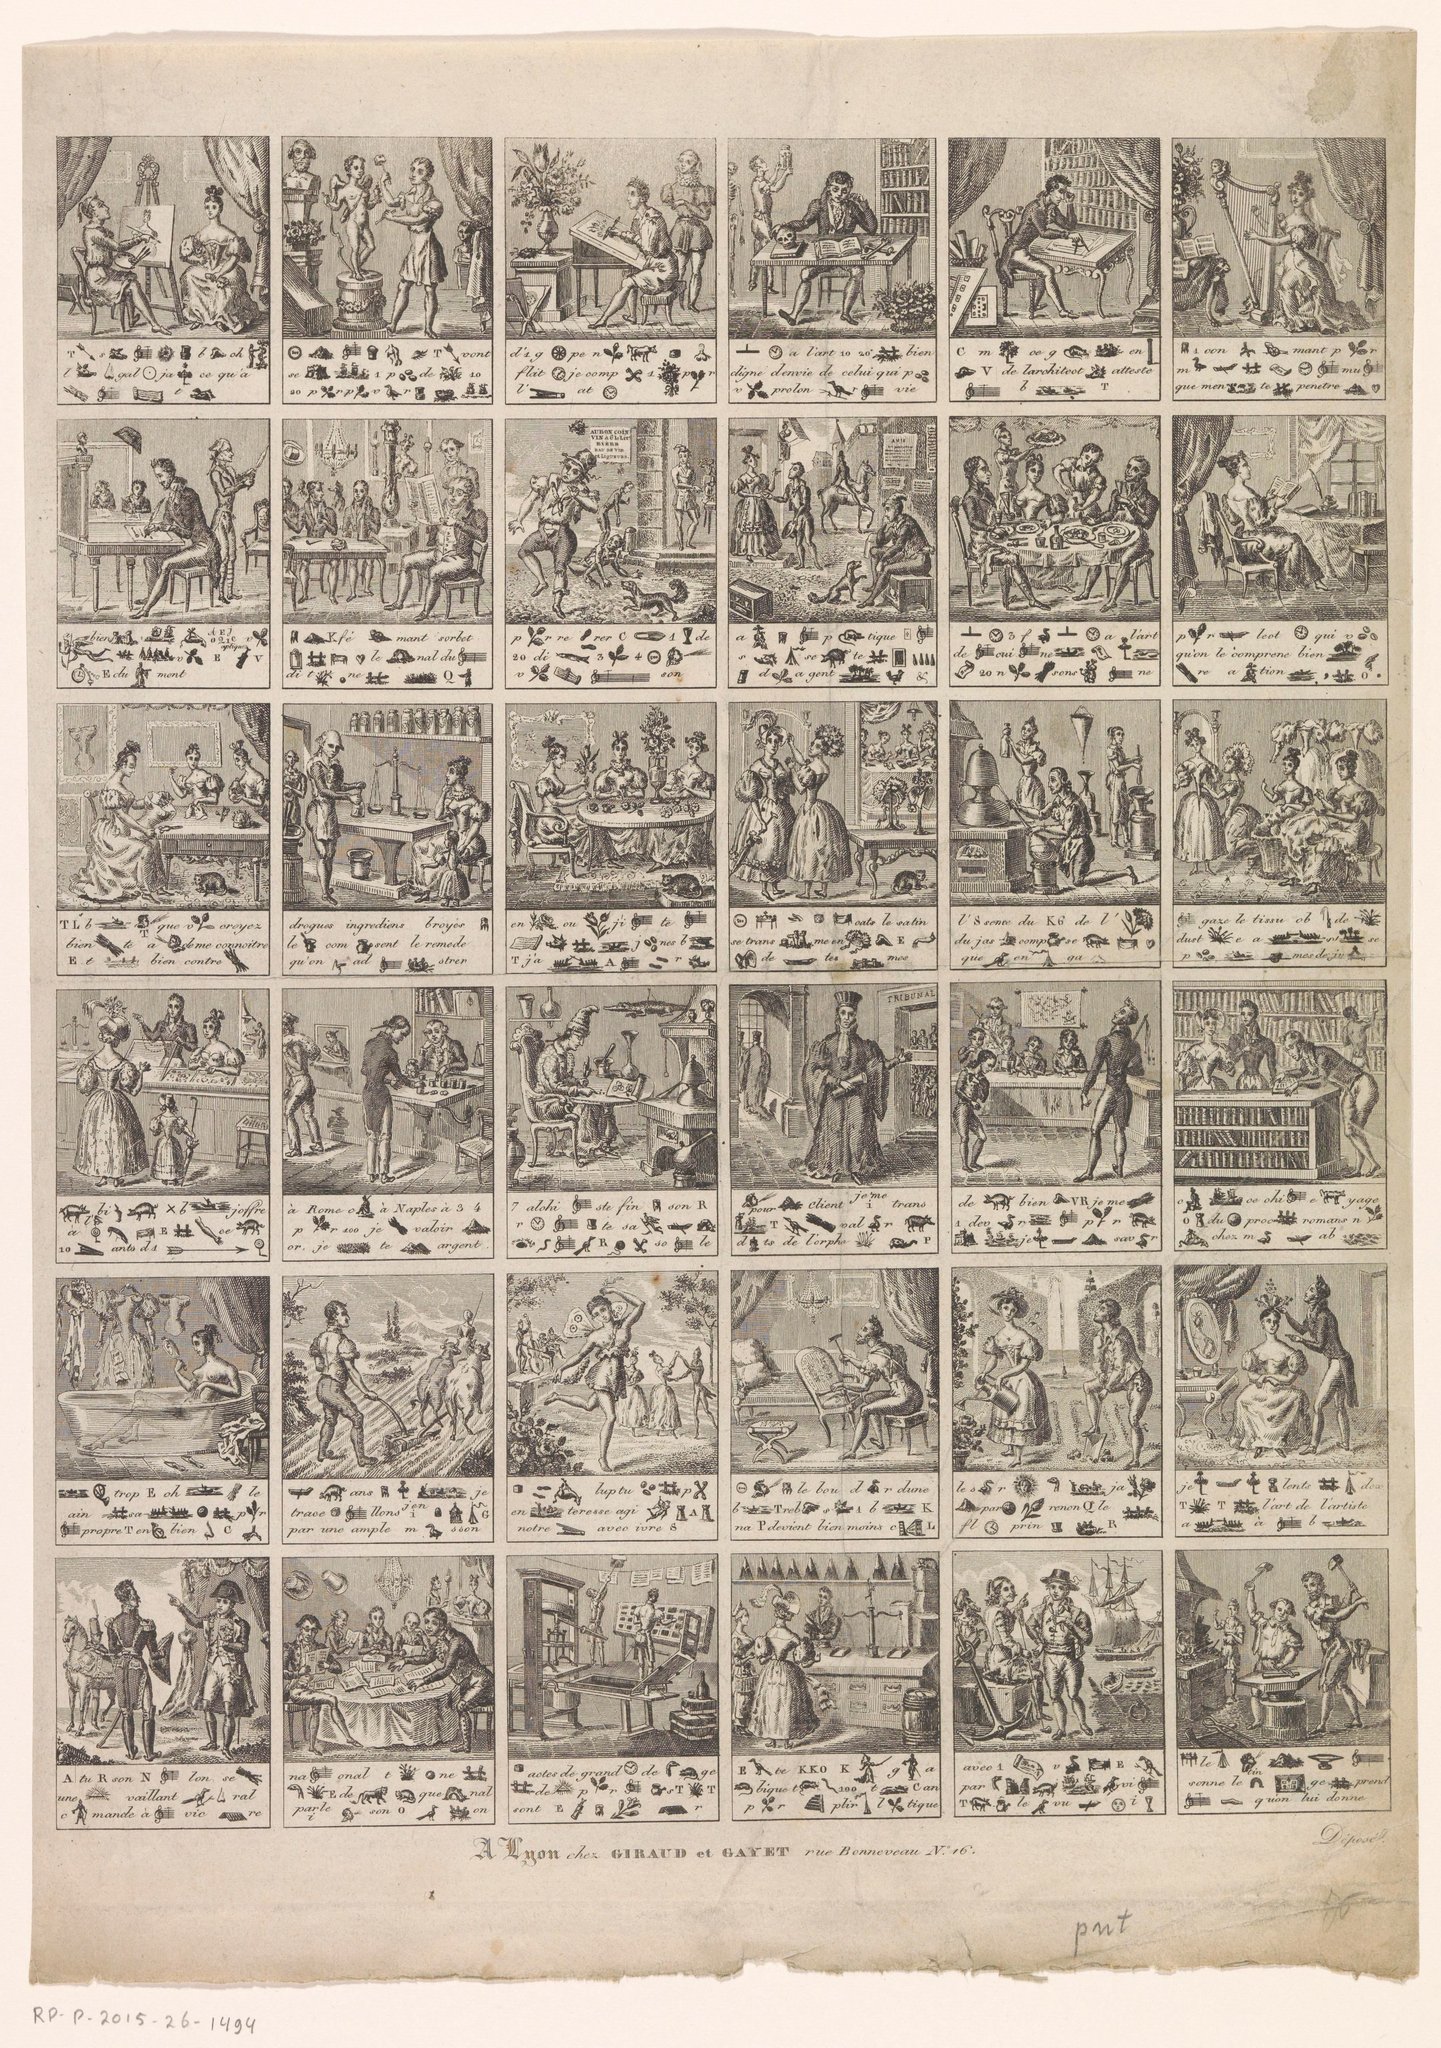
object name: rebus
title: Blad met zesendertig rebussen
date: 1820-1835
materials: paper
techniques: etching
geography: lyon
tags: printing press, book-shop, bookseller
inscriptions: collector's mark: Lugt 4780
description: Blad met zesendertig scènes, voornamelijk voorstellingen uit het dagelijks leven. Onder elke scène een driegelige rebus in het Frans. Onder de voorstellingen bevinden zich ook het interieur van een boekhandel en de werkplaats van een boekdrukker.